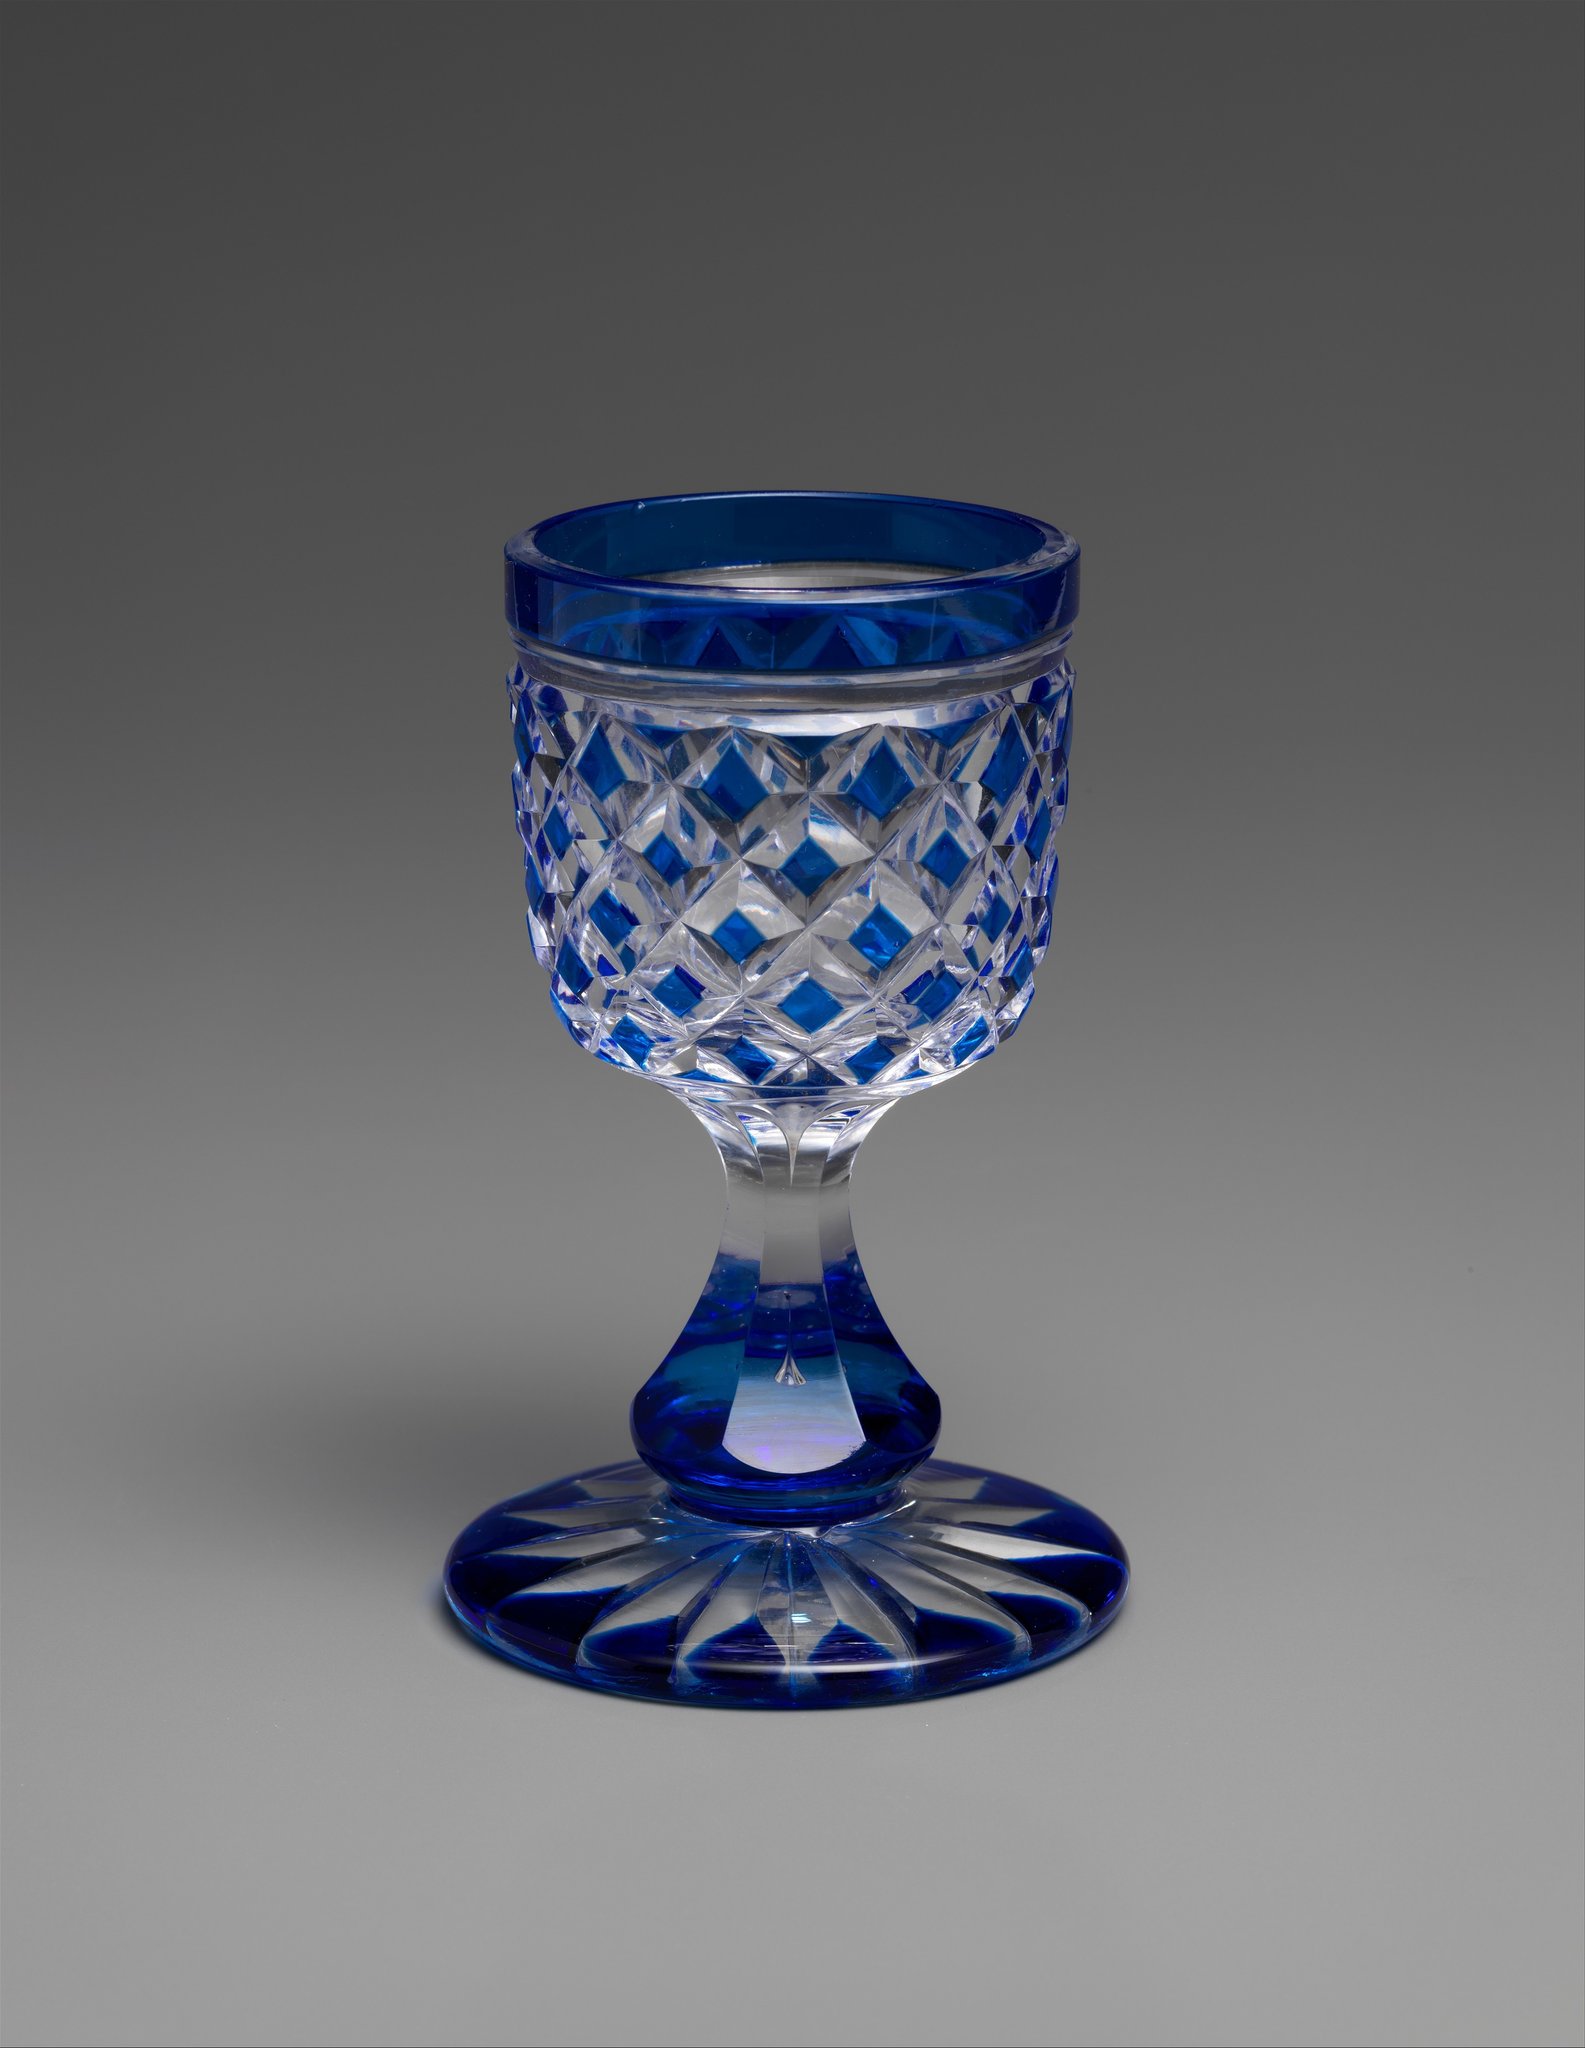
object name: cordial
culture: american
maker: brooklyn flint glass company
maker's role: manufacturer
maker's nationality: american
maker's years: 1824-1868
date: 1850-1855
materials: glass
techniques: cutting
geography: united states